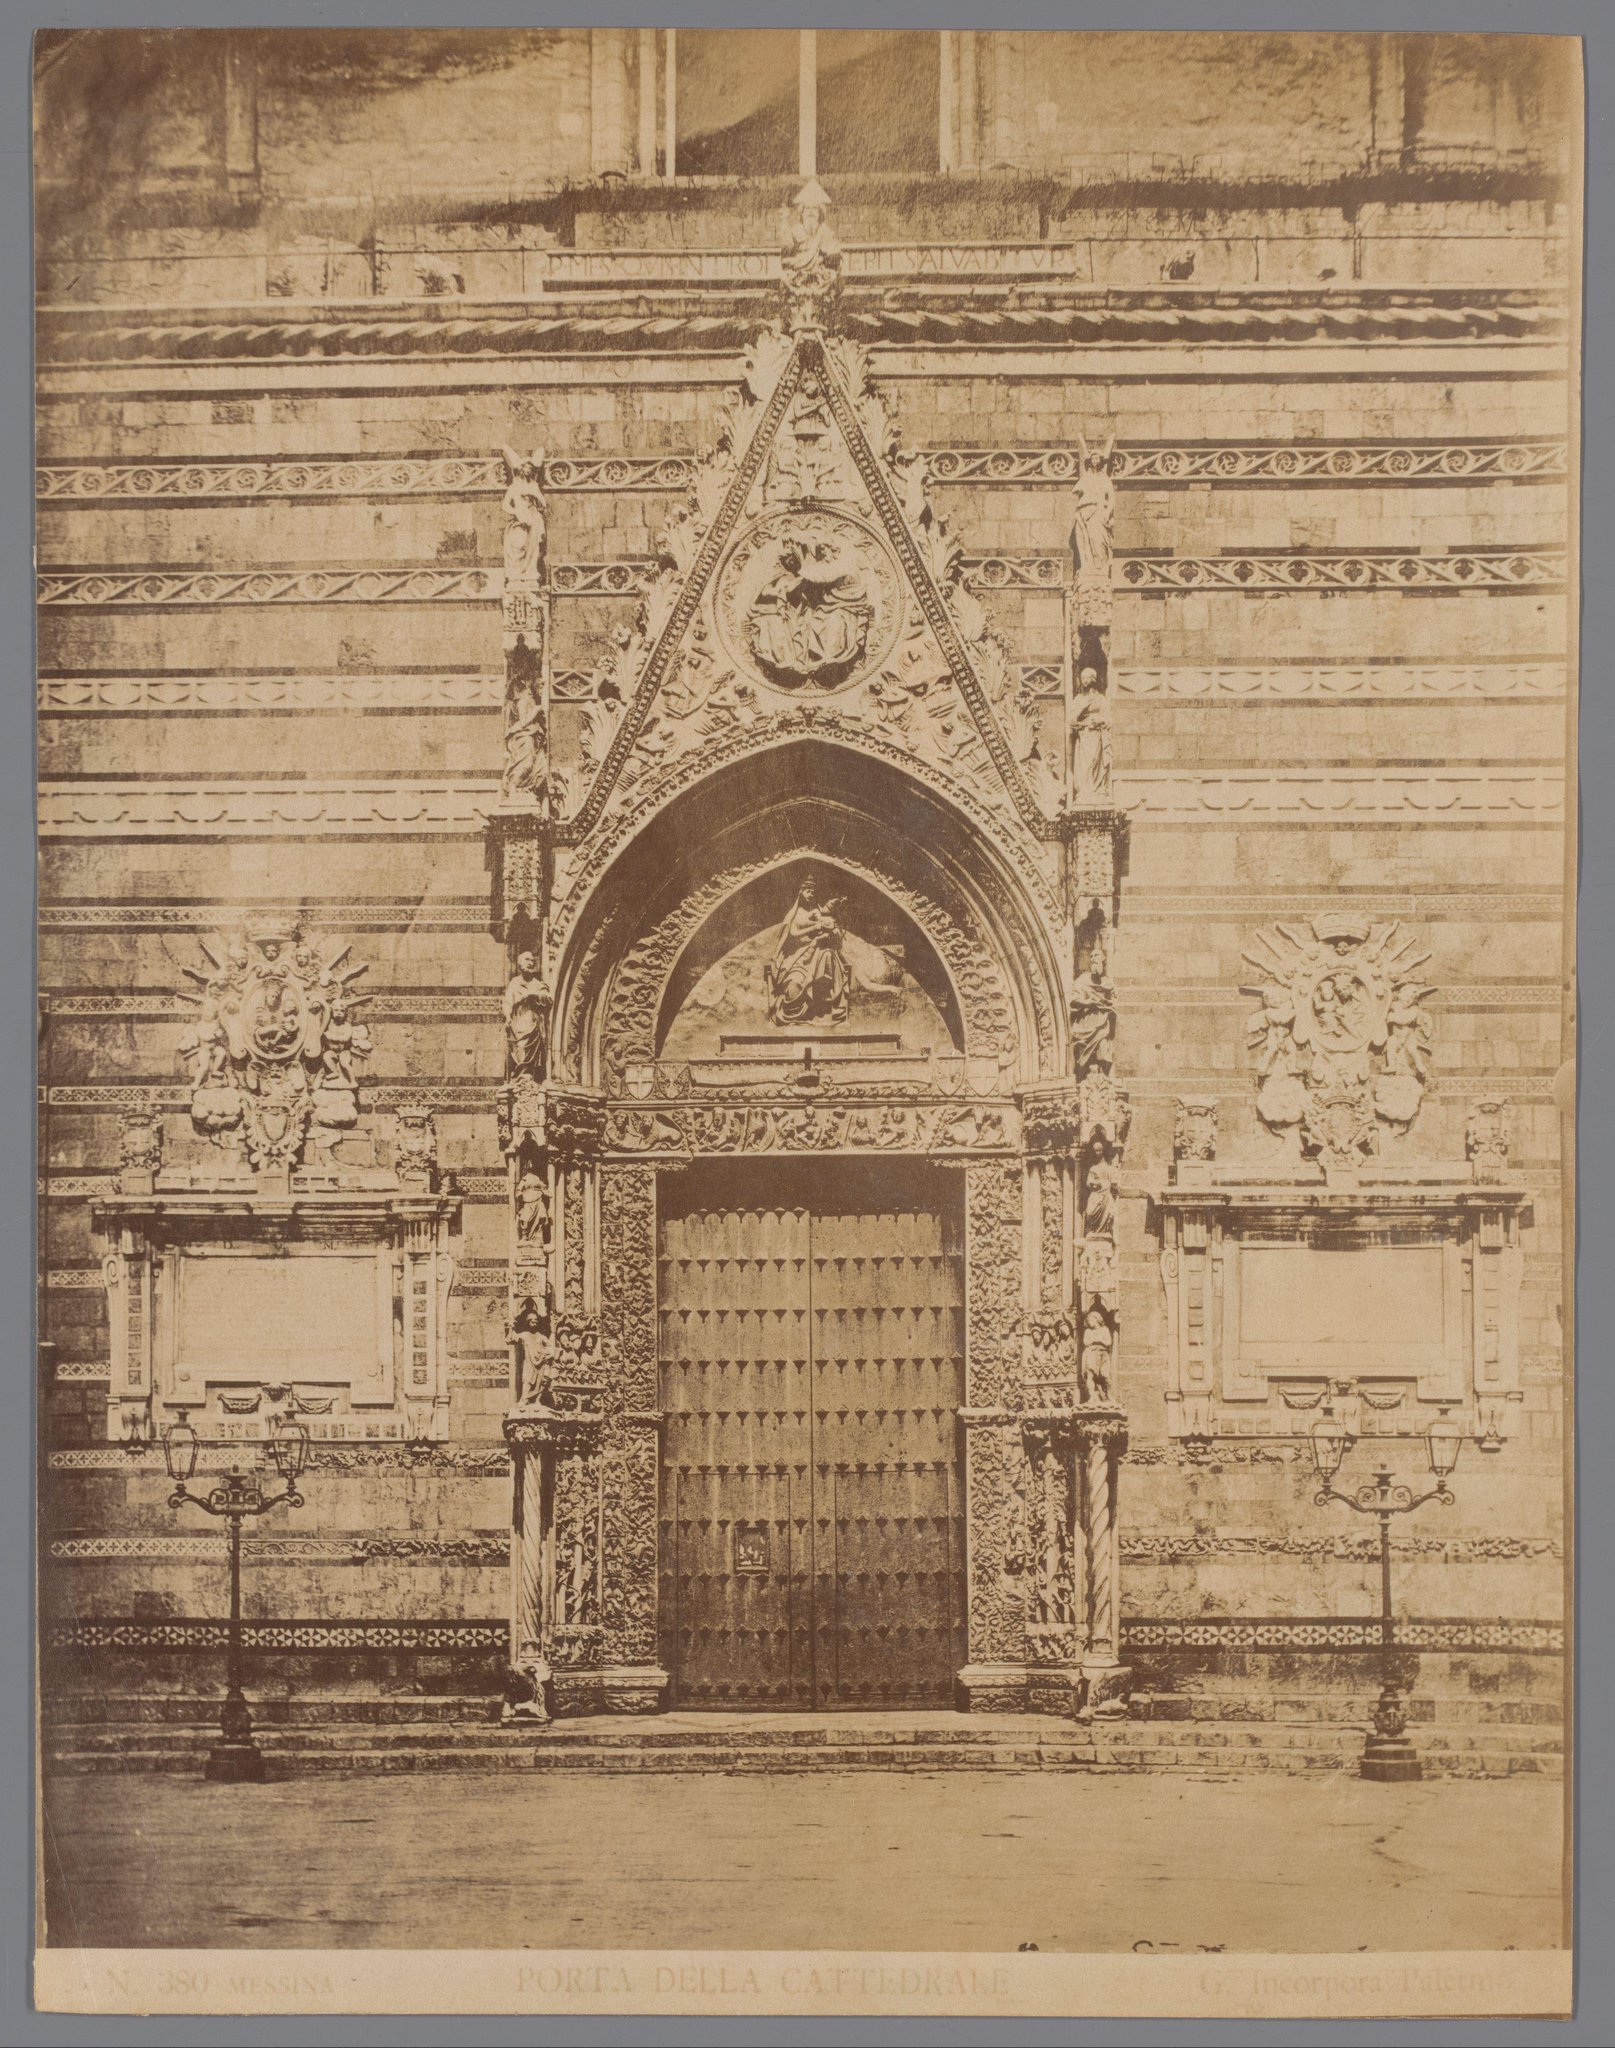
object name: photograph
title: Portaal van de kathedraal van Messina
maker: giuseppe incorpora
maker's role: fotograaf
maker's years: 1834-1914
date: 1856-1914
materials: paper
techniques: albumen print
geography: messina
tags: parts of church exterior and annexes: portal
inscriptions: number: ‘N. 380’